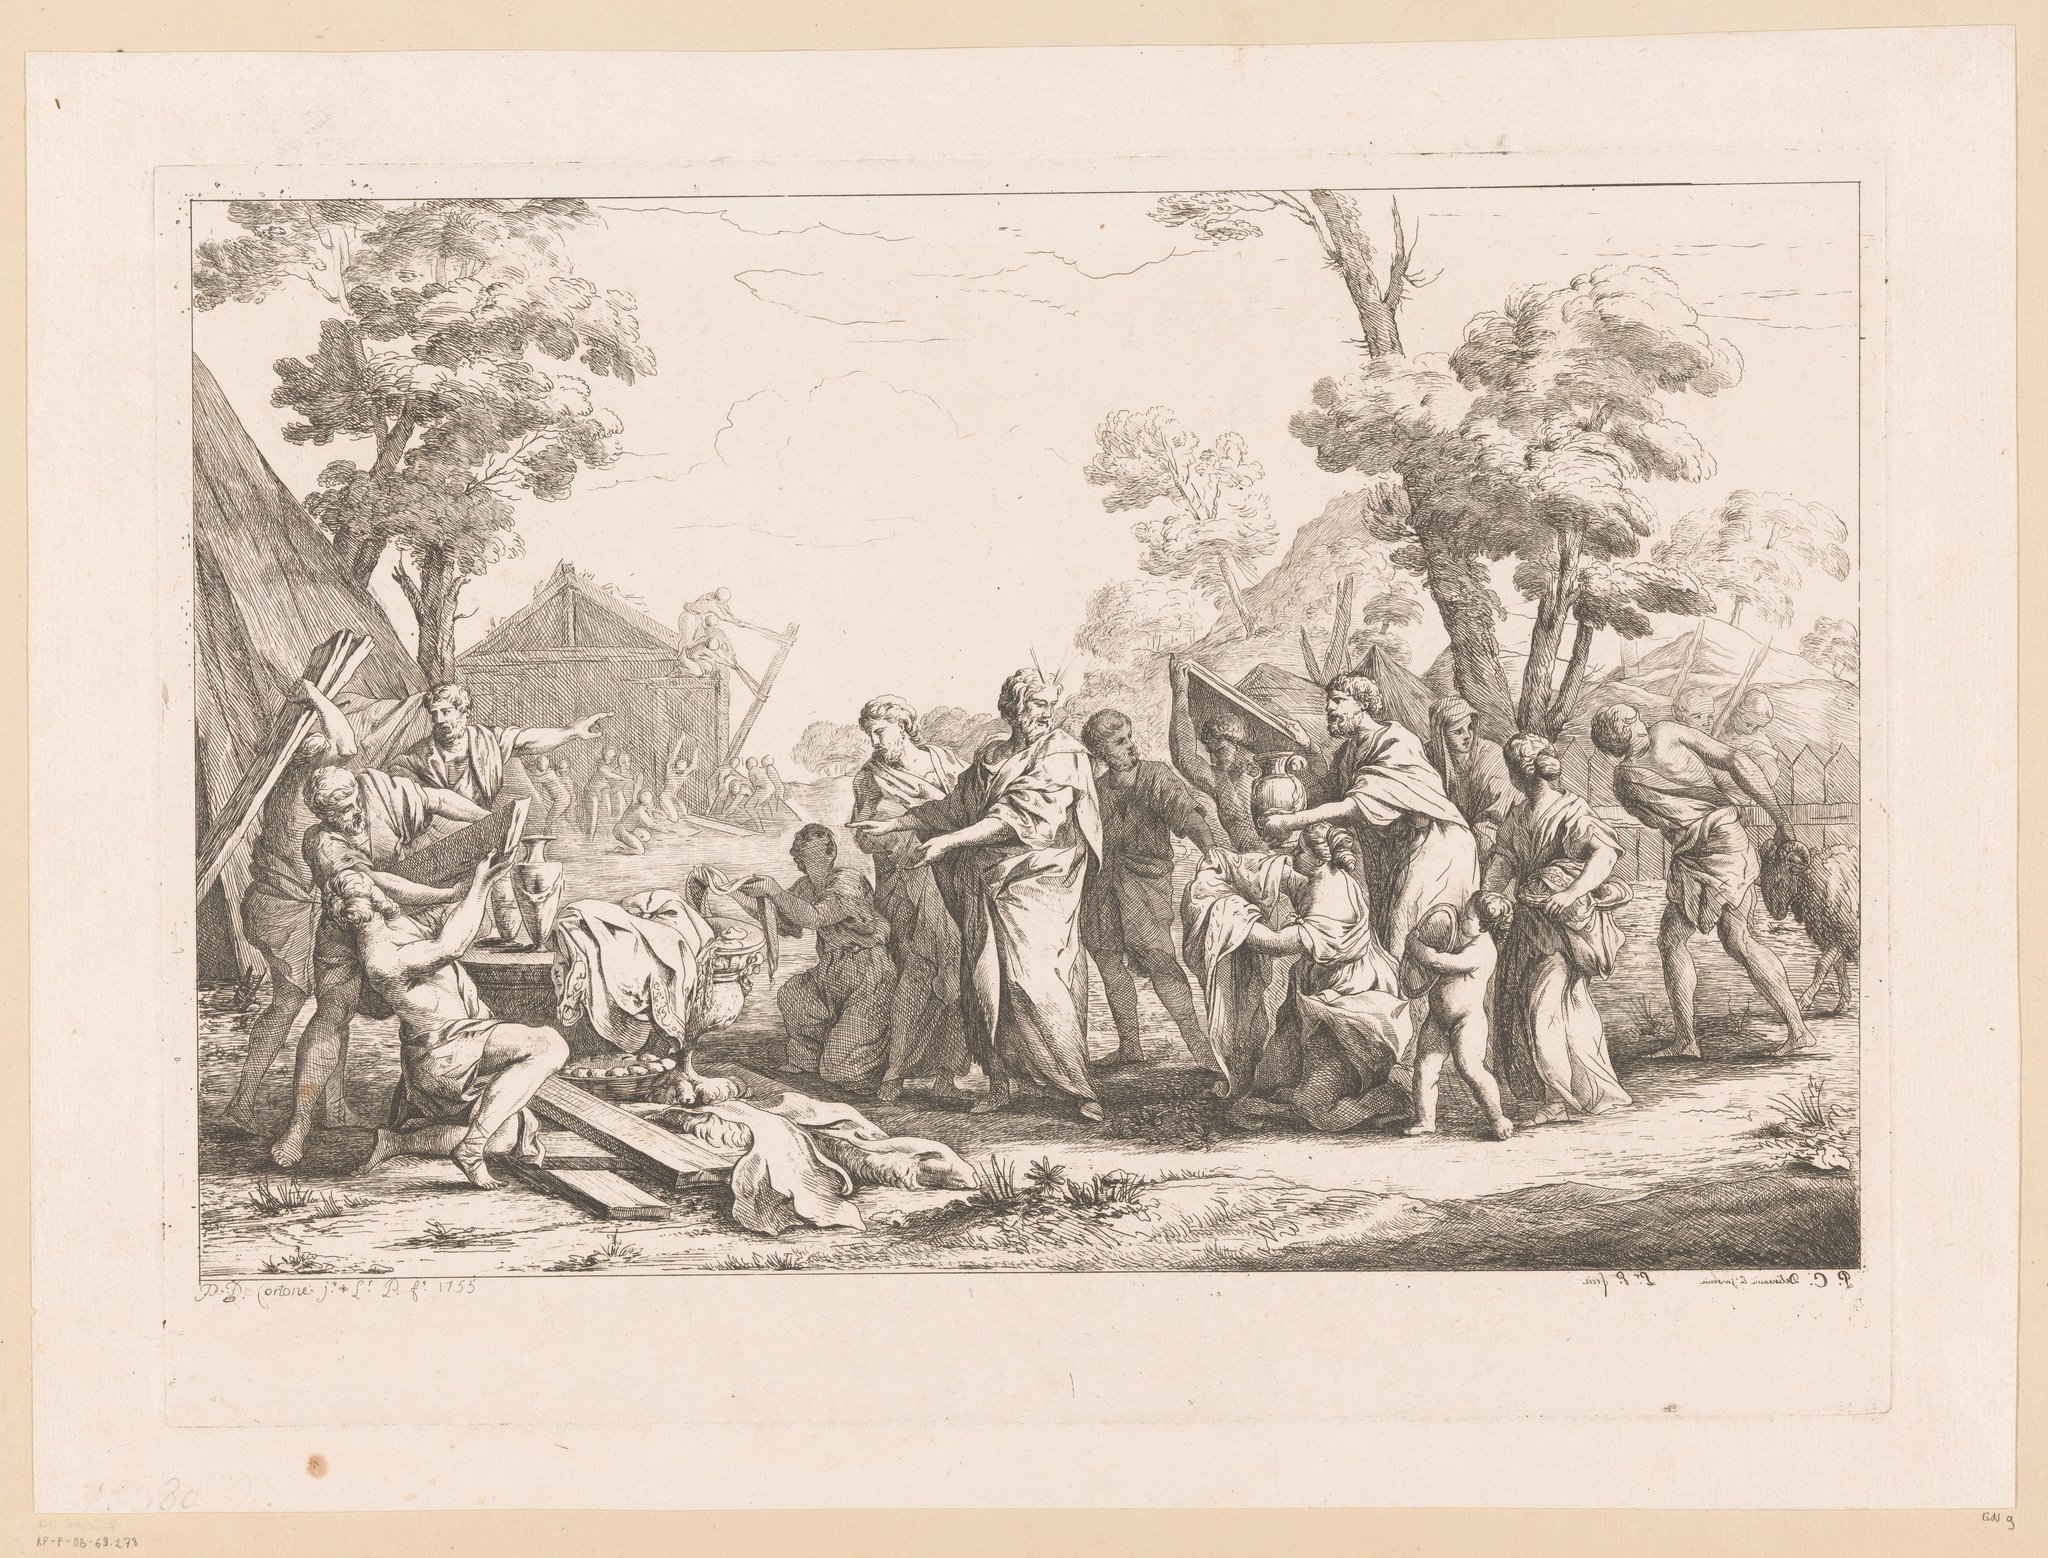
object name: print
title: Mozes en de Israëlieten bouwen een onderkomen voor de tafelen der wet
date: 1755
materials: paper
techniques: engraving, etching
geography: france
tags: the tabernacle is set up and moses puts the ark with the tables in it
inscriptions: watermark, collector's mark: Lugt 240, inscription: ‘present van monsieur Lampereur a paris’